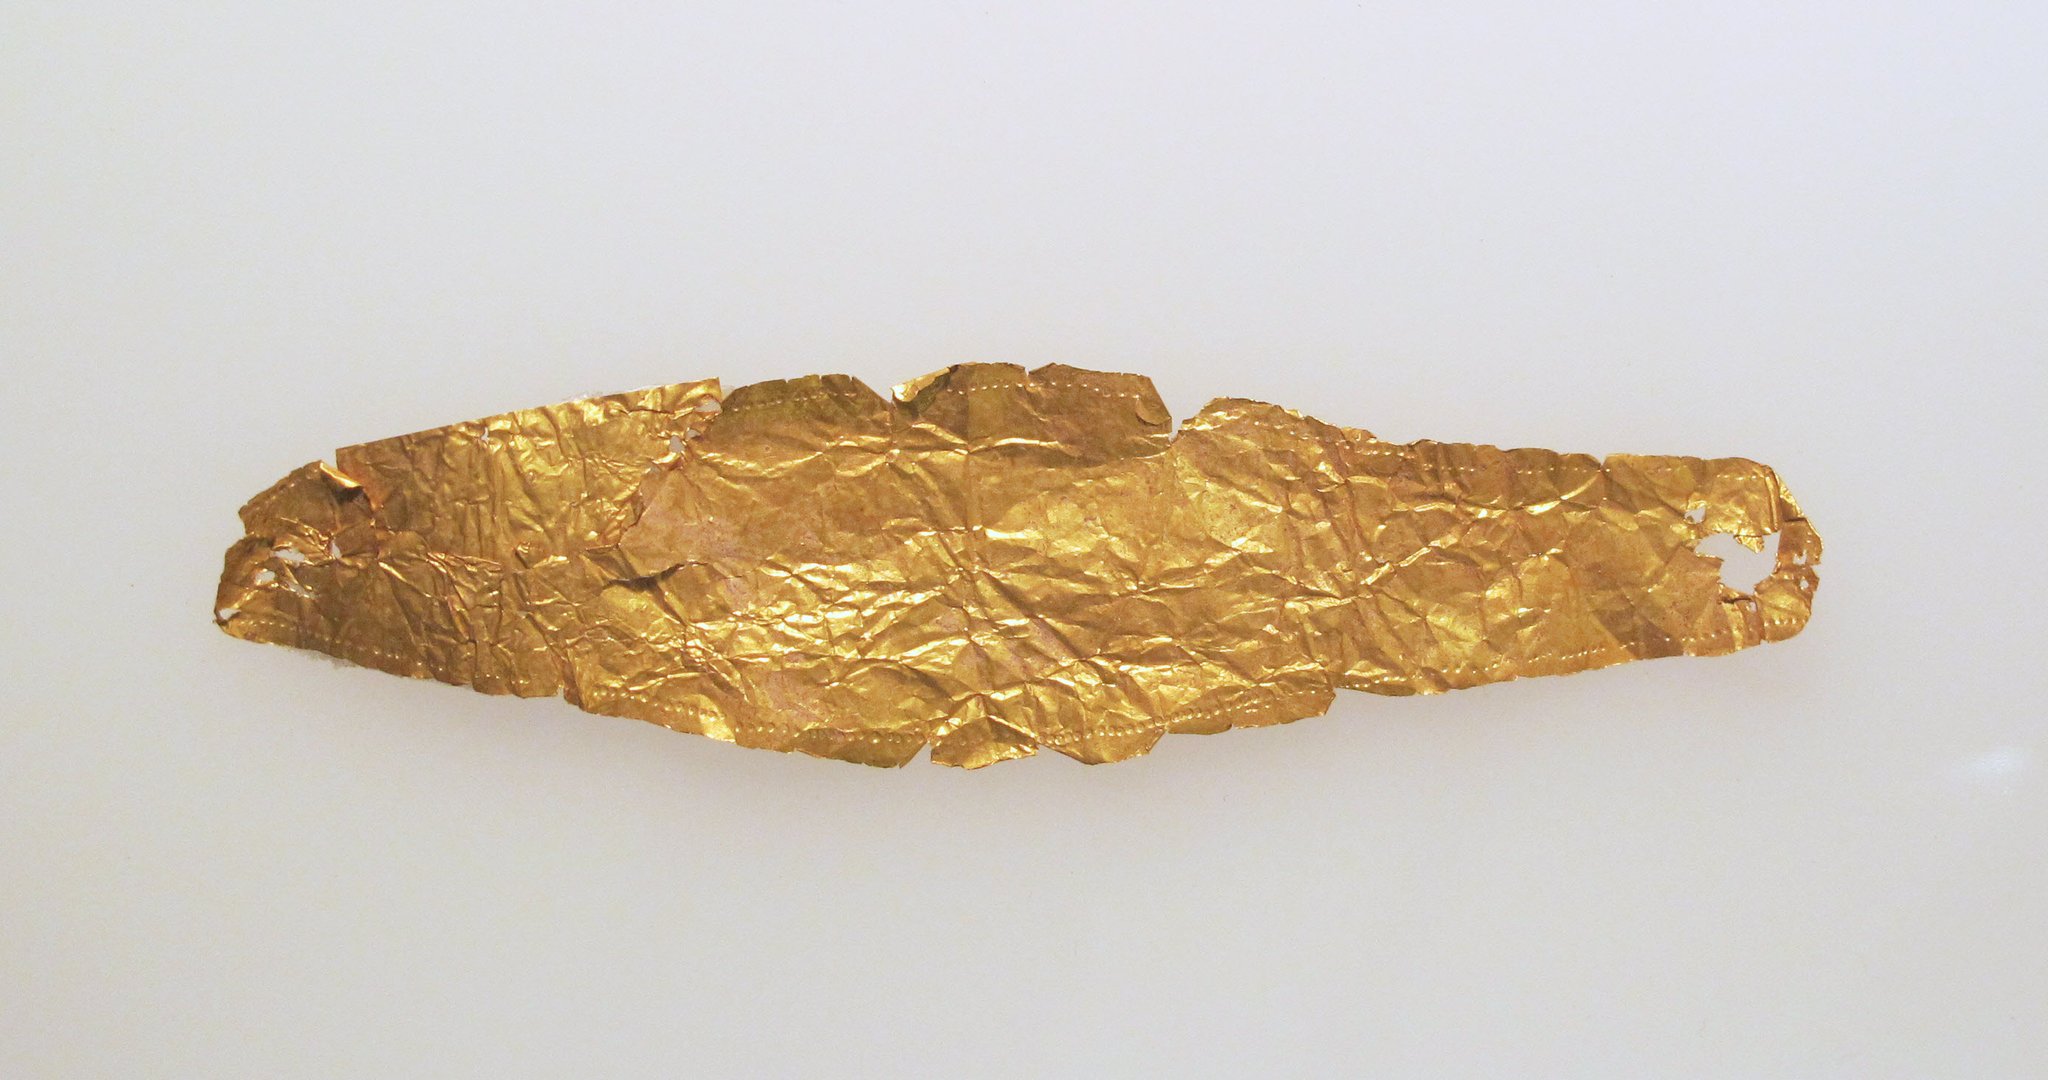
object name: frontlet of gold leaf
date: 7000 BCE-330 CE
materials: gold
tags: leaves